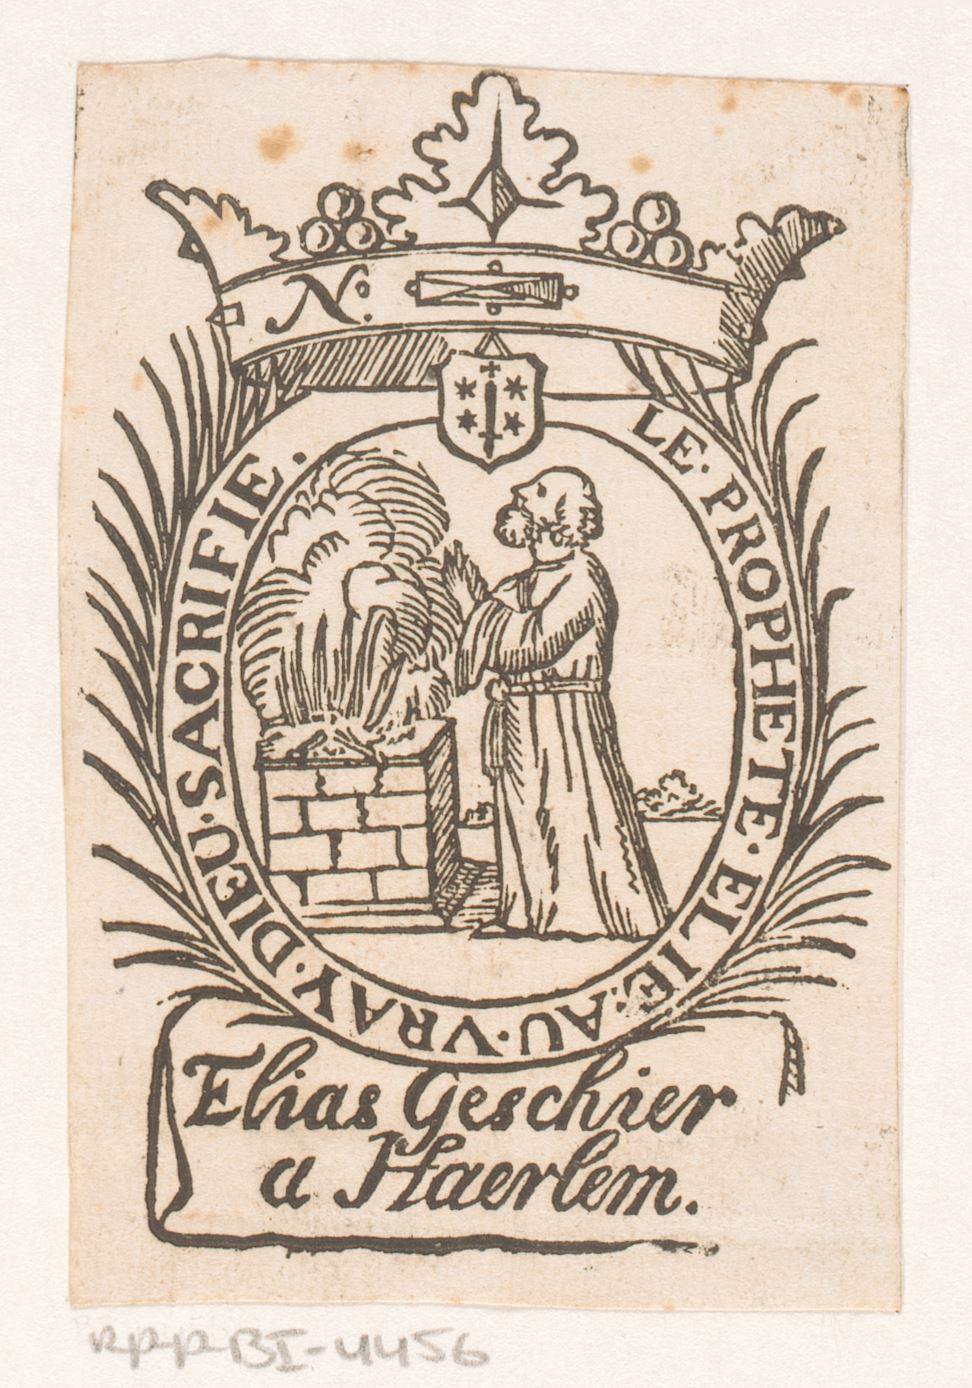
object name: print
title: Vignet van Elias Geschier te Haarlem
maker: Anonymous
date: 1600-1699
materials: paper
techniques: woodcut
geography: netherlands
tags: coat of arms (as symbol of the state, etc.) (+ city; municipal), male persons from the old testament (with name) (not in biblical context), crown (symbol of sovereignty), vignette, haarlem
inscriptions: collector's mark: Lugt 240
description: De profeet Elia bij een brandend offerblok in een ovaal met randschrift. Midden boven een kroon en het wapen van de stad Haarlem.